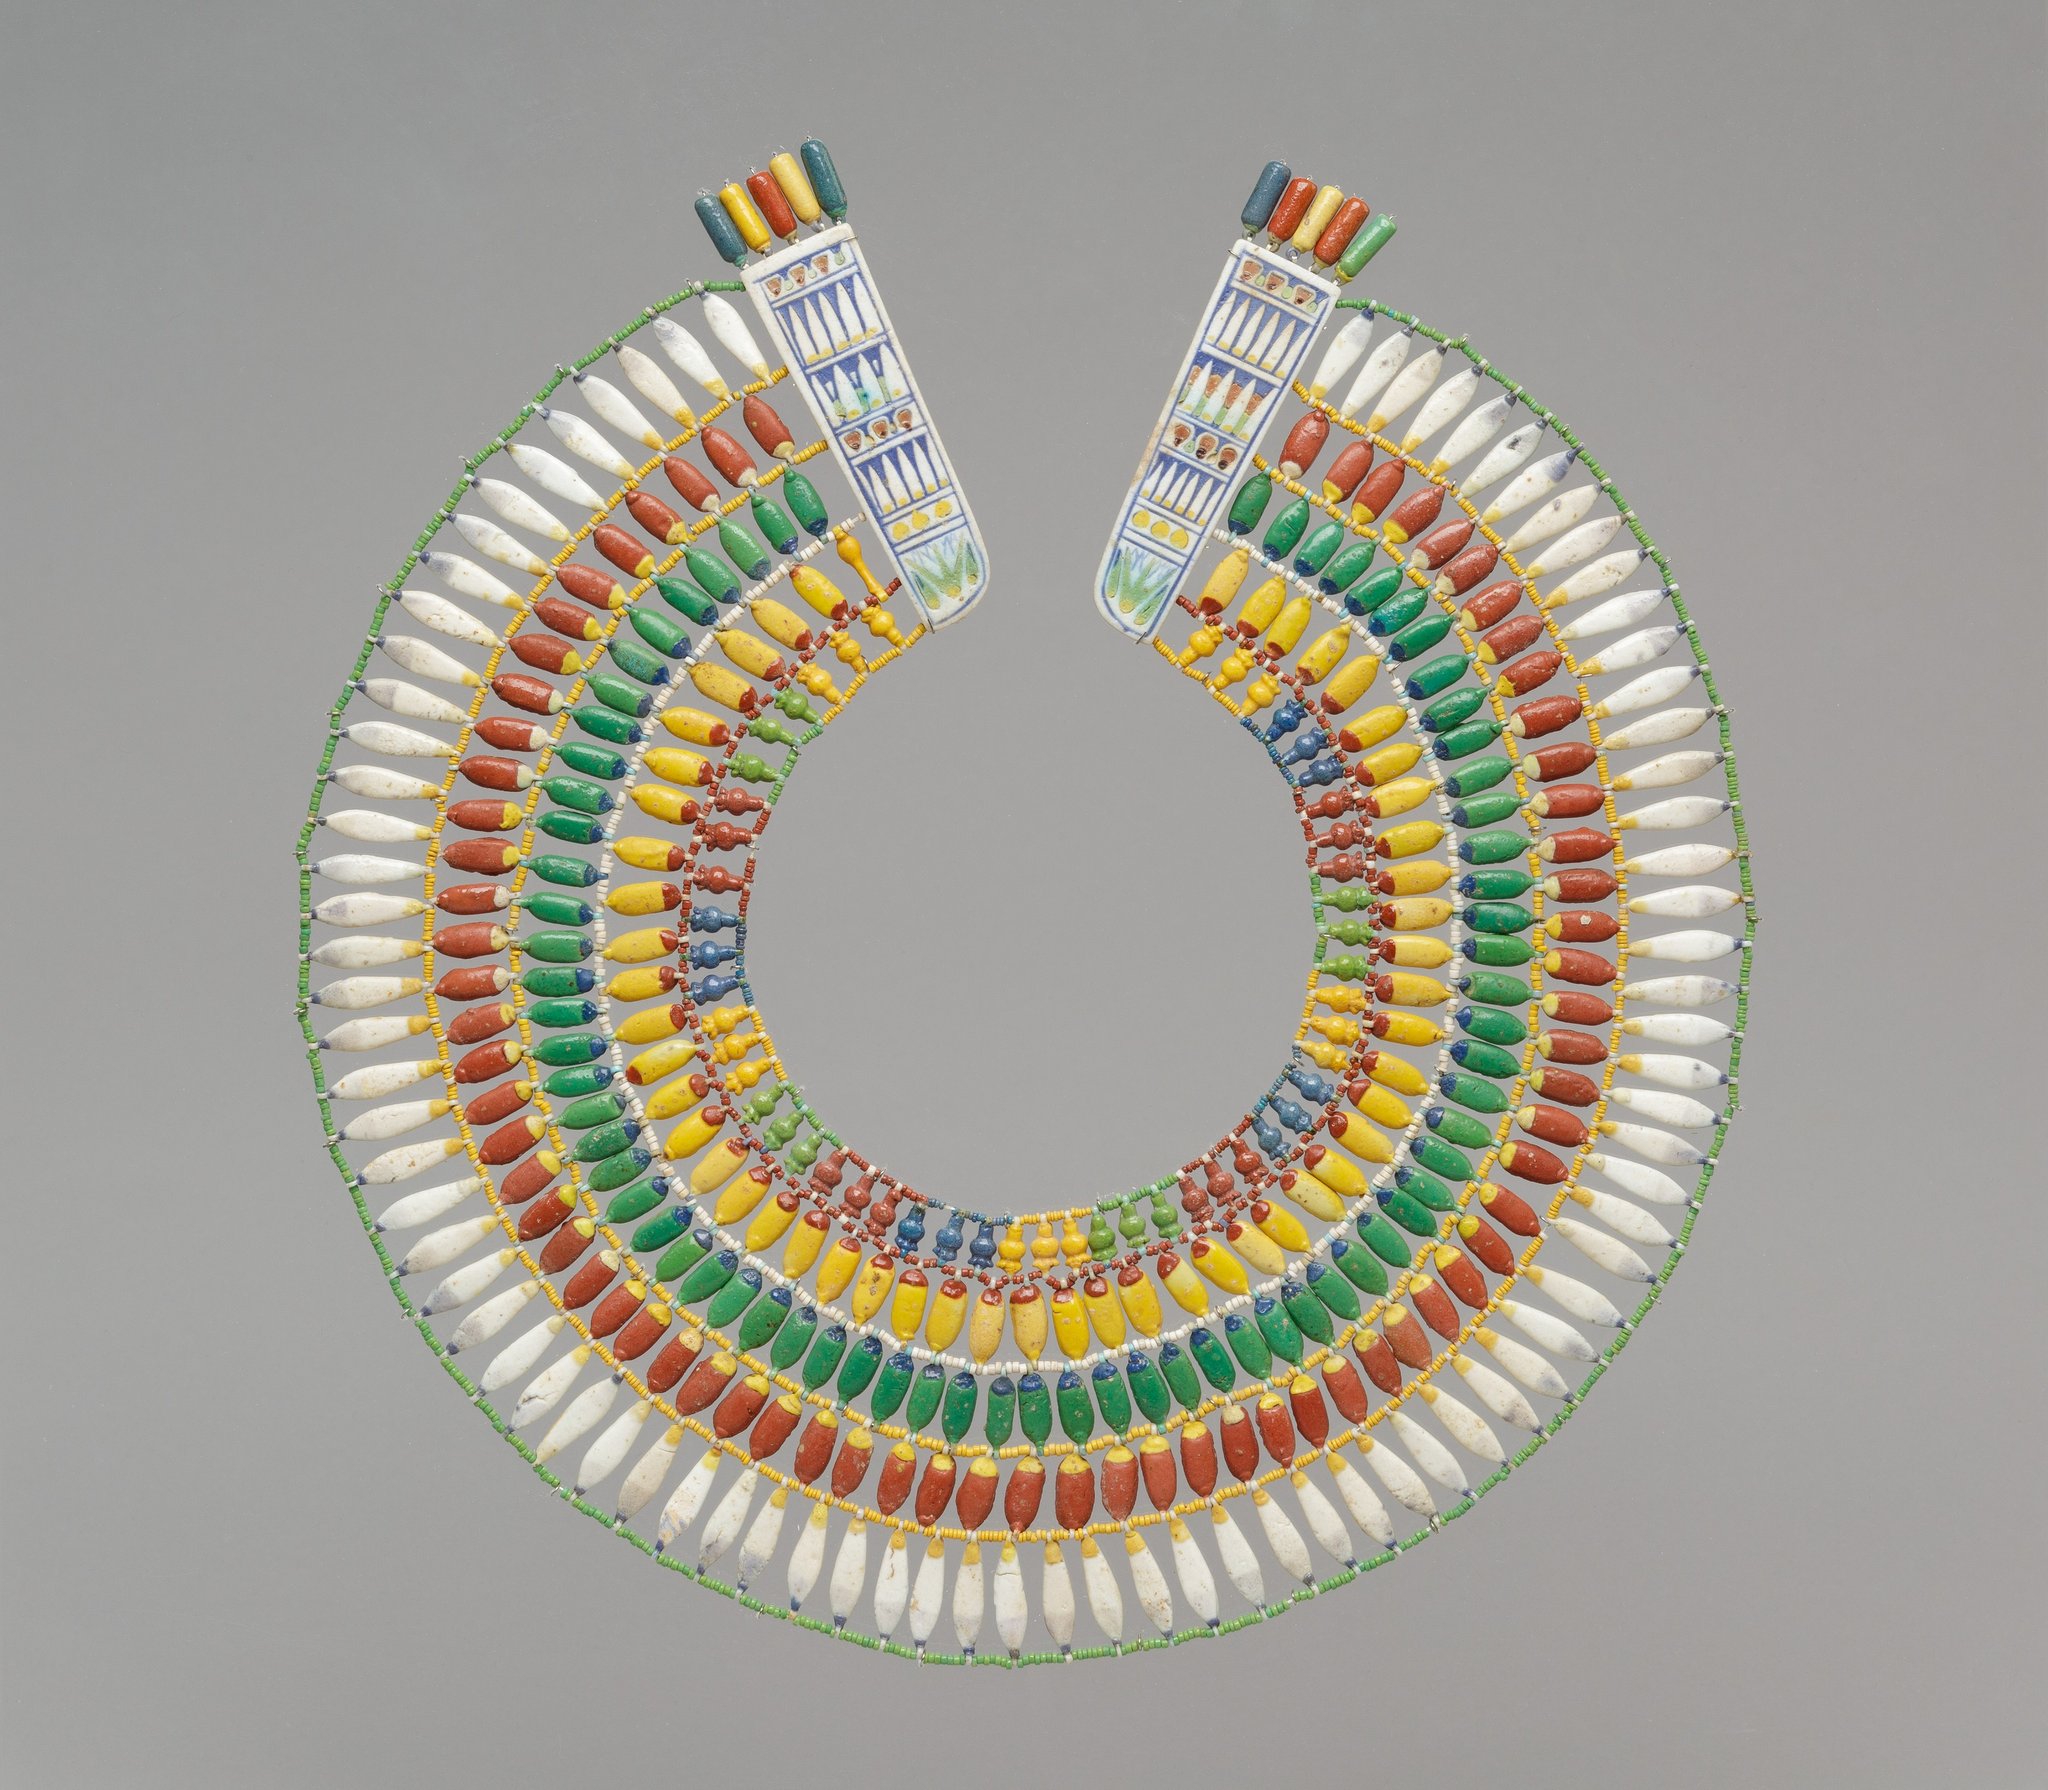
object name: broad collar, bead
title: Broad Collar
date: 1353-1336 BCE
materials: faience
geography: egypt